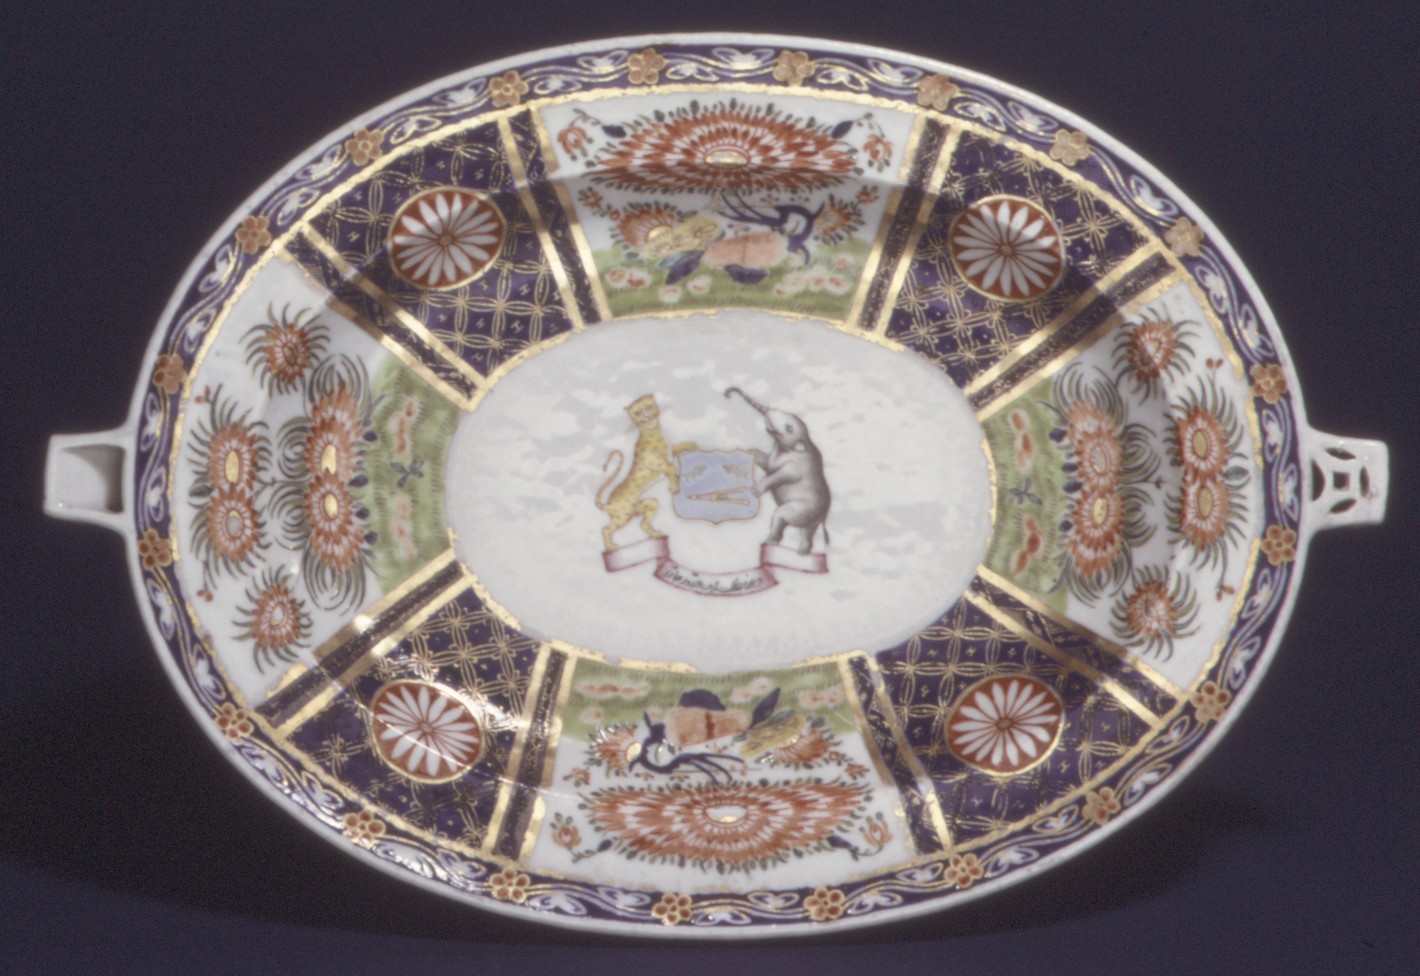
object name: hot water plate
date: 1840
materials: hard paste porcelain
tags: elephants,tigers,flowers,coat of arms